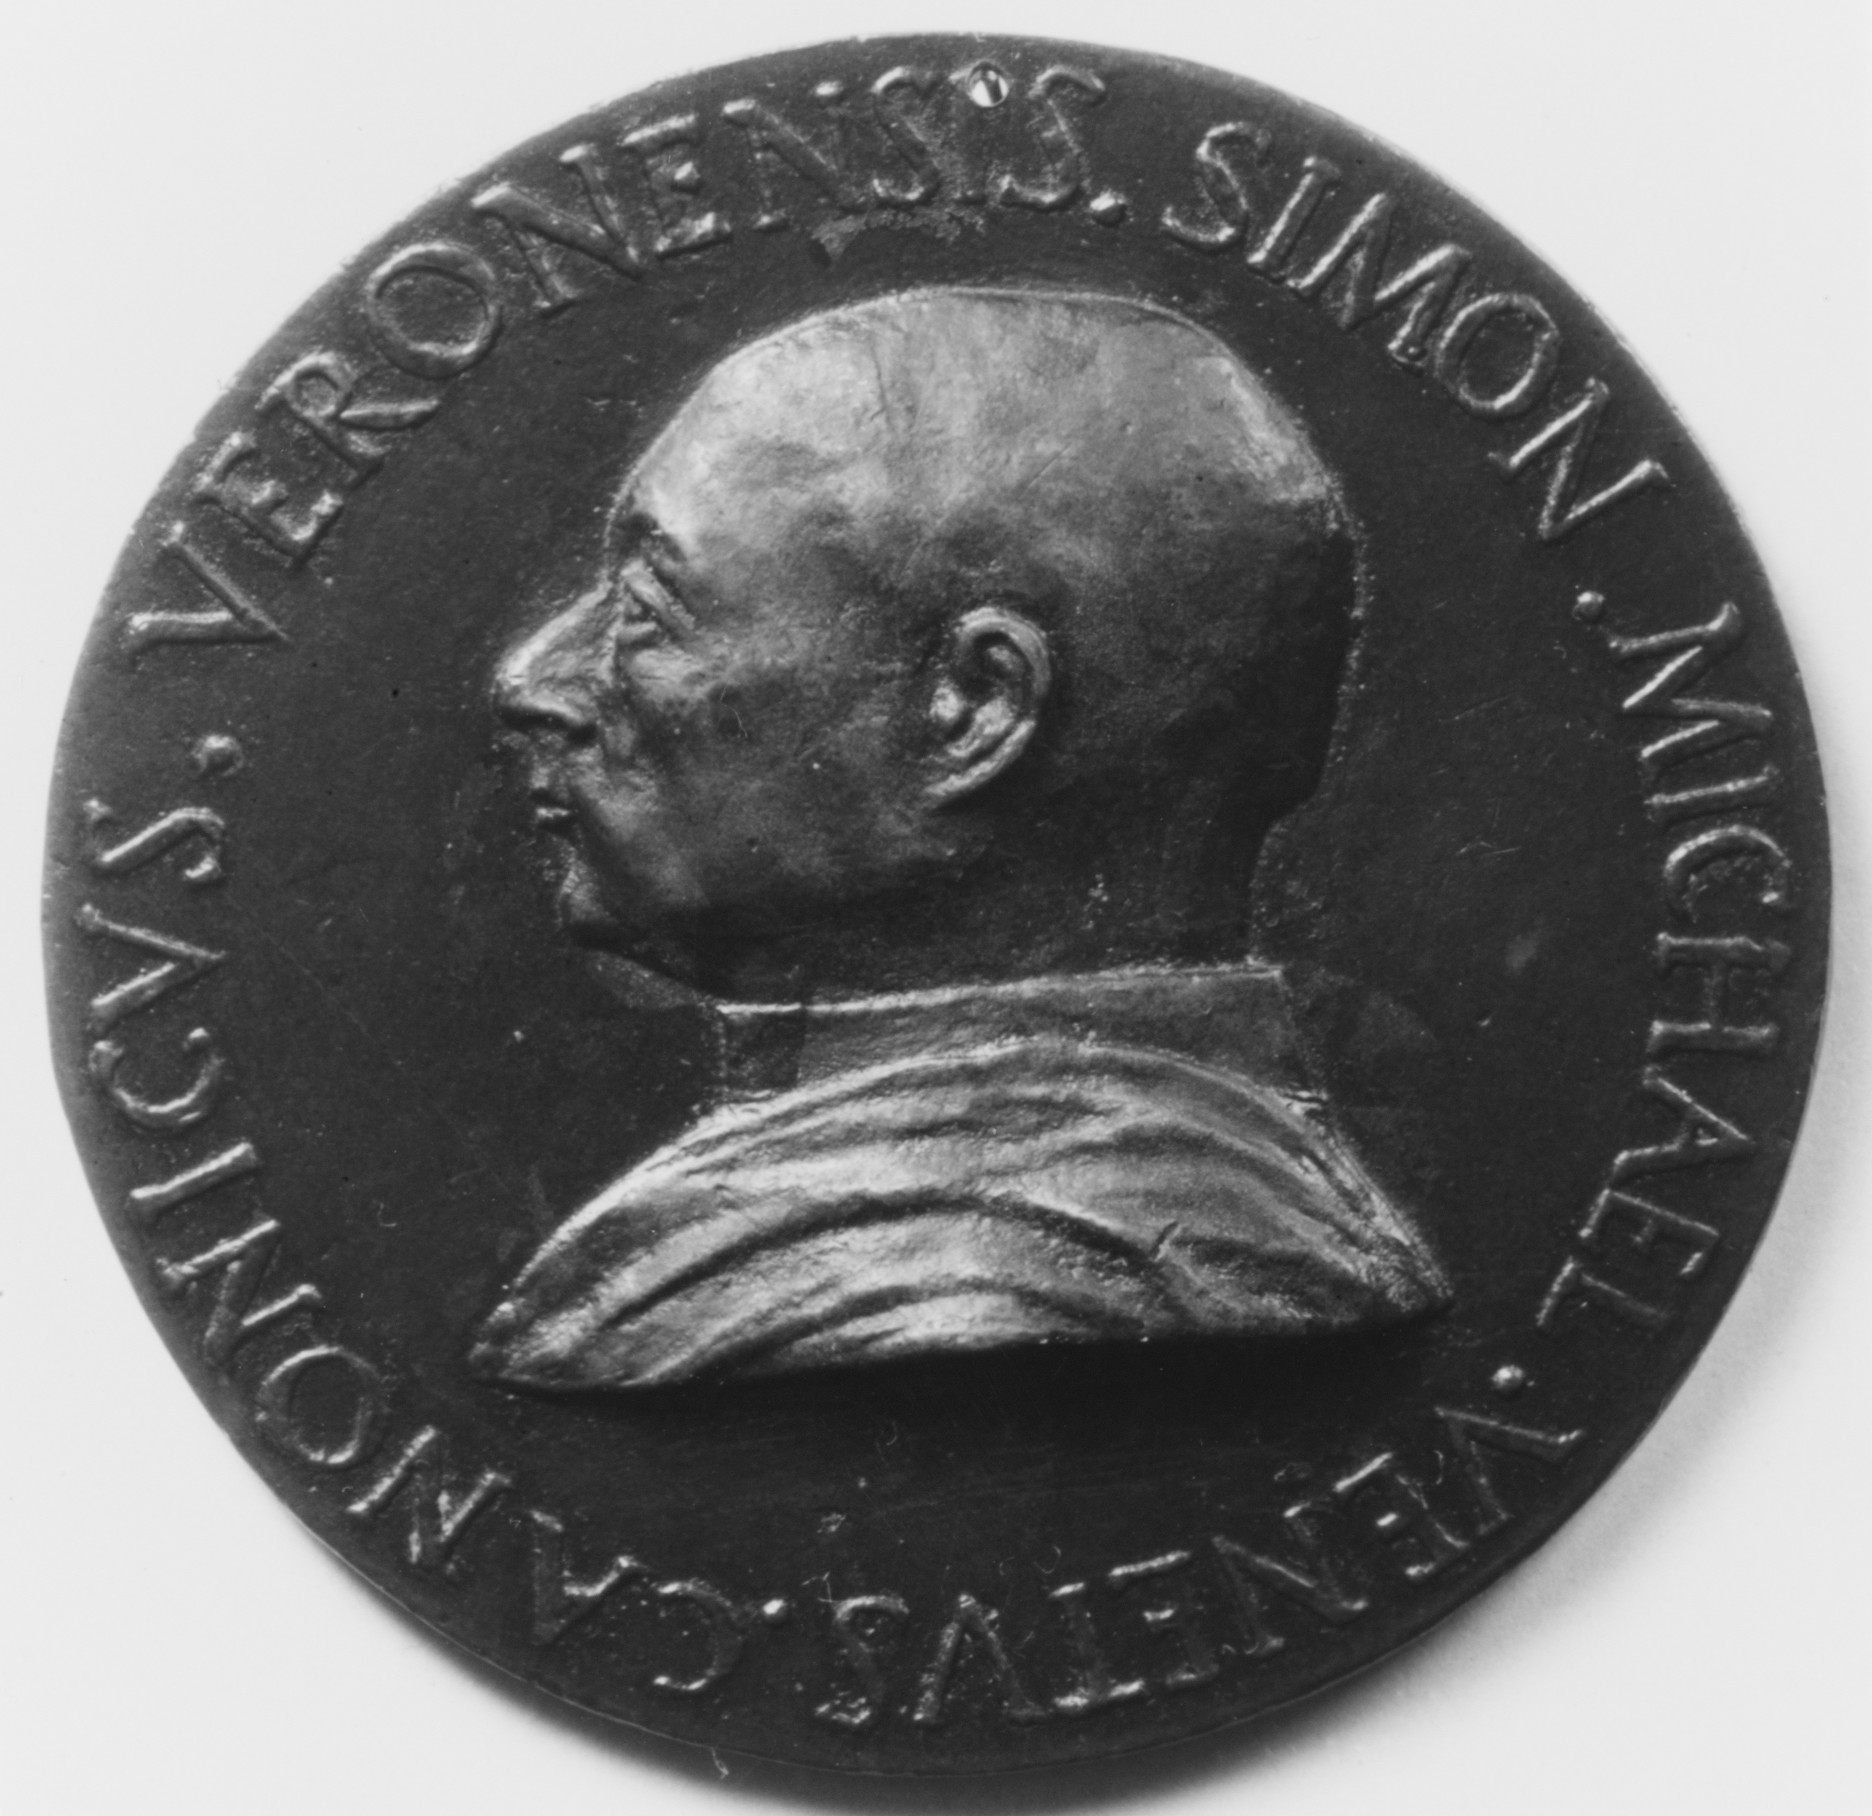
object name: medal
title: Simone Michieli, Canon of Verona (1498–1535)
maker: fra antonio da brescia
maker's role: artist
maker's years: 1480-1525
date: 1515-1525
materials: bronze, patina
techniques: casting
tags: men,profiles